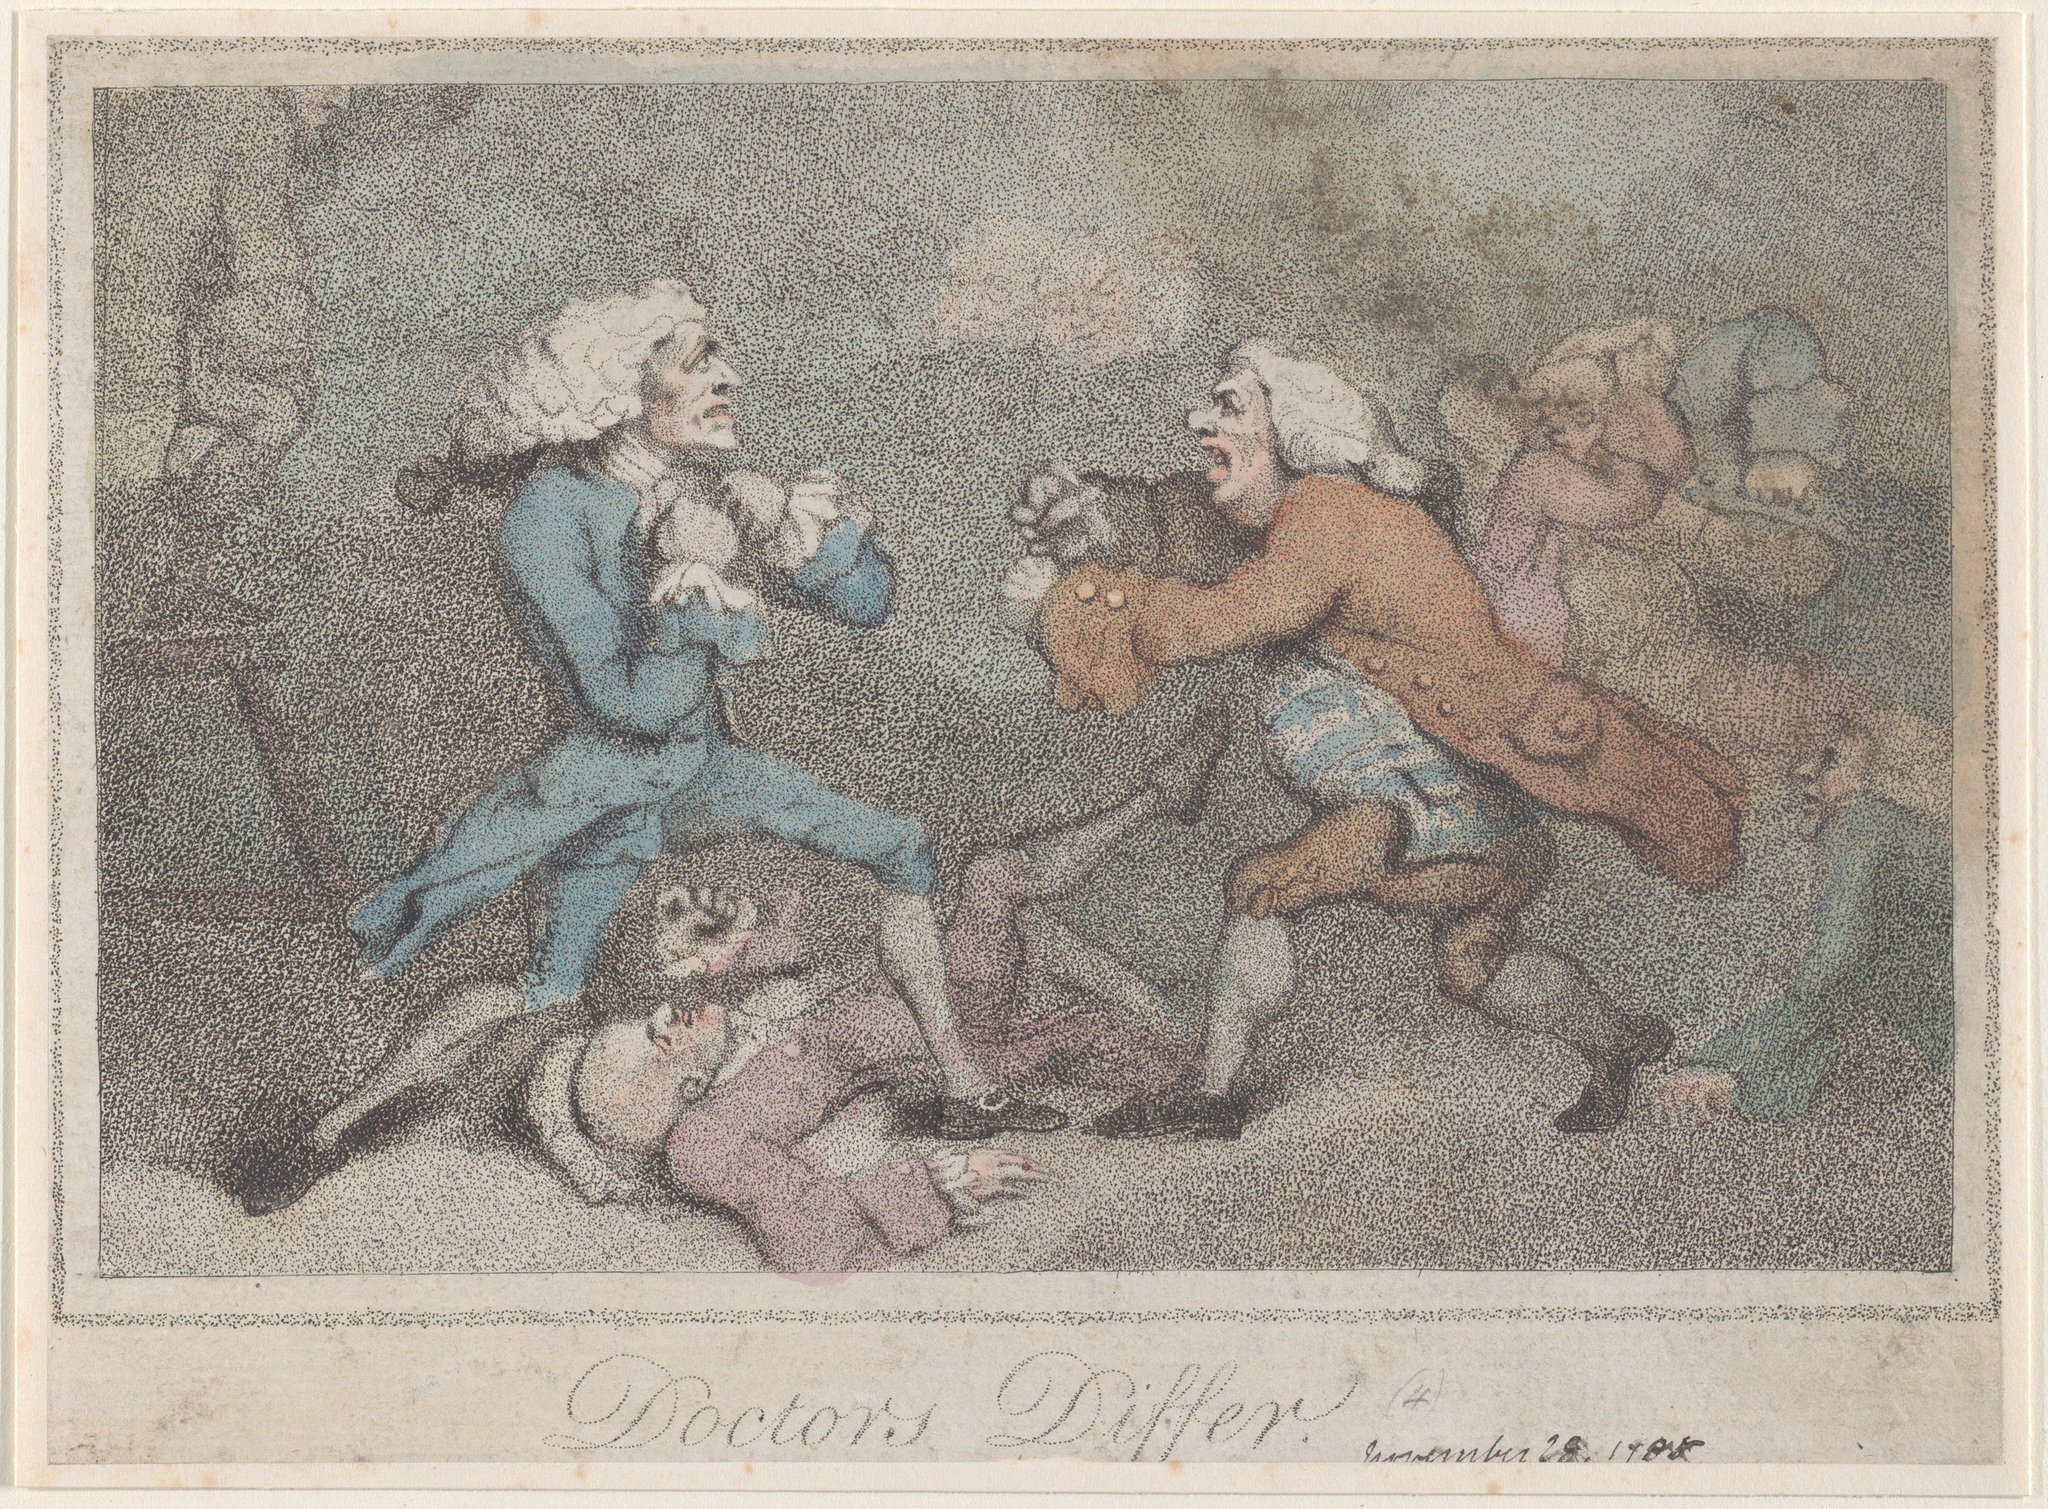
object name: print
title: Doctors Differ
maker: thomas rowlandson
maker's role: artist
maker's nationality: british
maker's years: 1757-1827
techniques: hand coloring, engraving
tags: satire,men